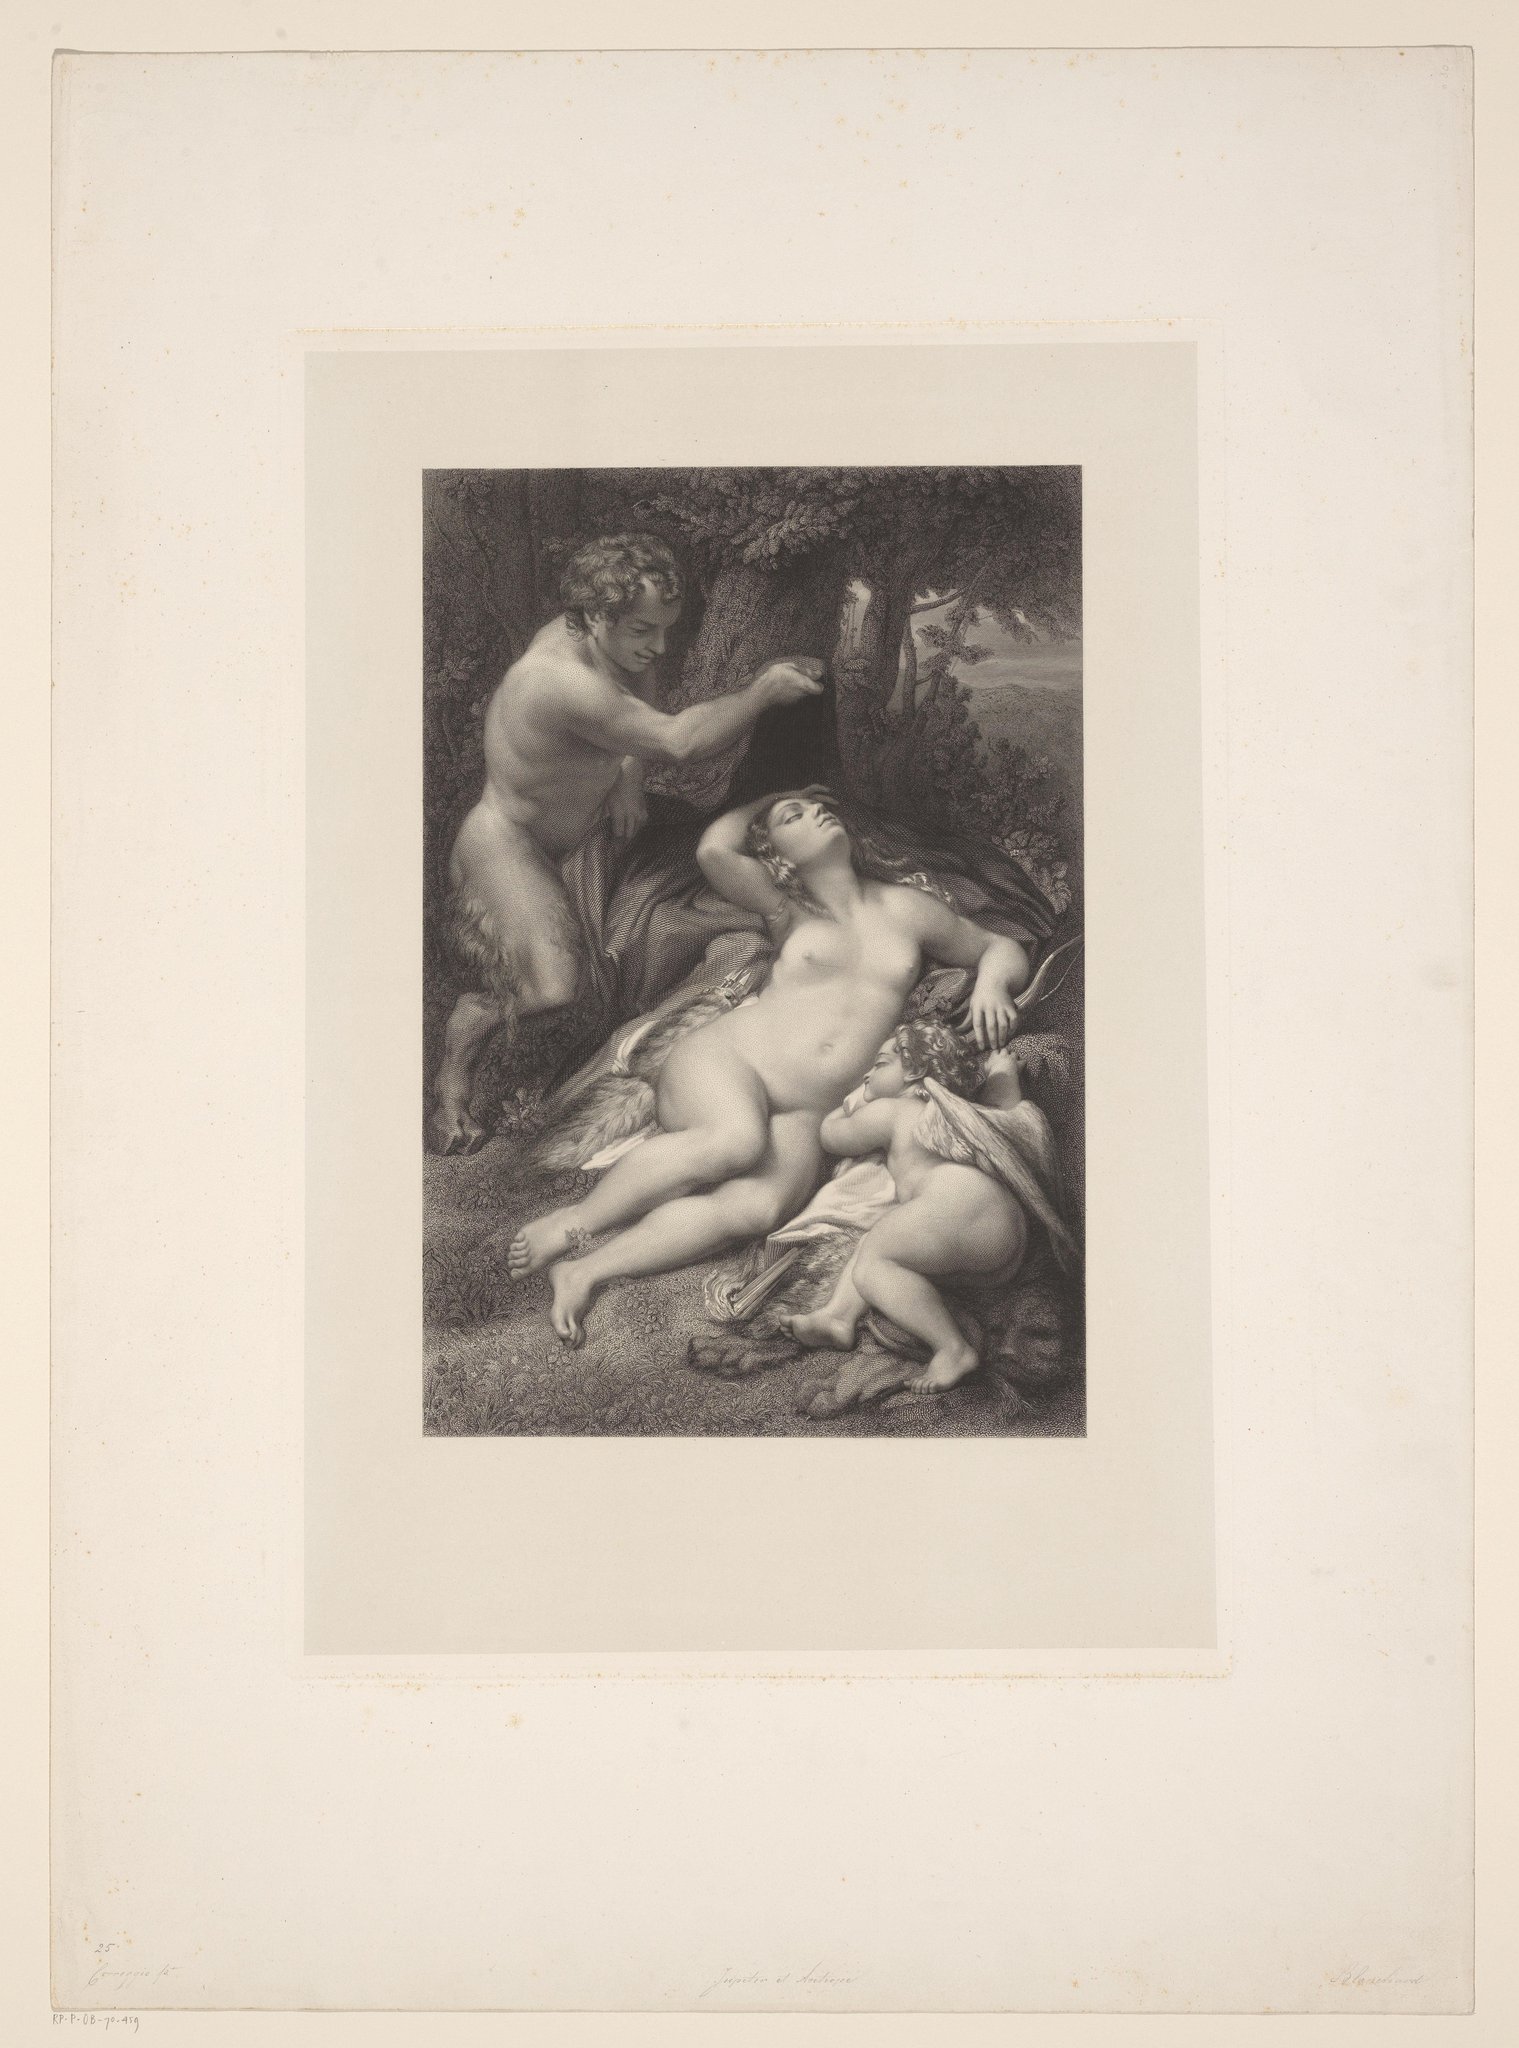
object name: print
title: Jupiter en Antiope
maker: auguste thomas marie blanchard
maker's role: print maker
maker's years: 1819-1898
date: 1857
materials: paper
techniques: engraving, etching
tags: jupiter, disguised as a satyr, approaches the sleeping antiope; the eagle may be standing nearby, (story of) cupid, amor (eros)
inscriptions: collector's mark: Lugt 12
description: Een liggende Antiope wordt verrast door Jupiter in de gedaante van een satyr. Naast haar ligt Eros.